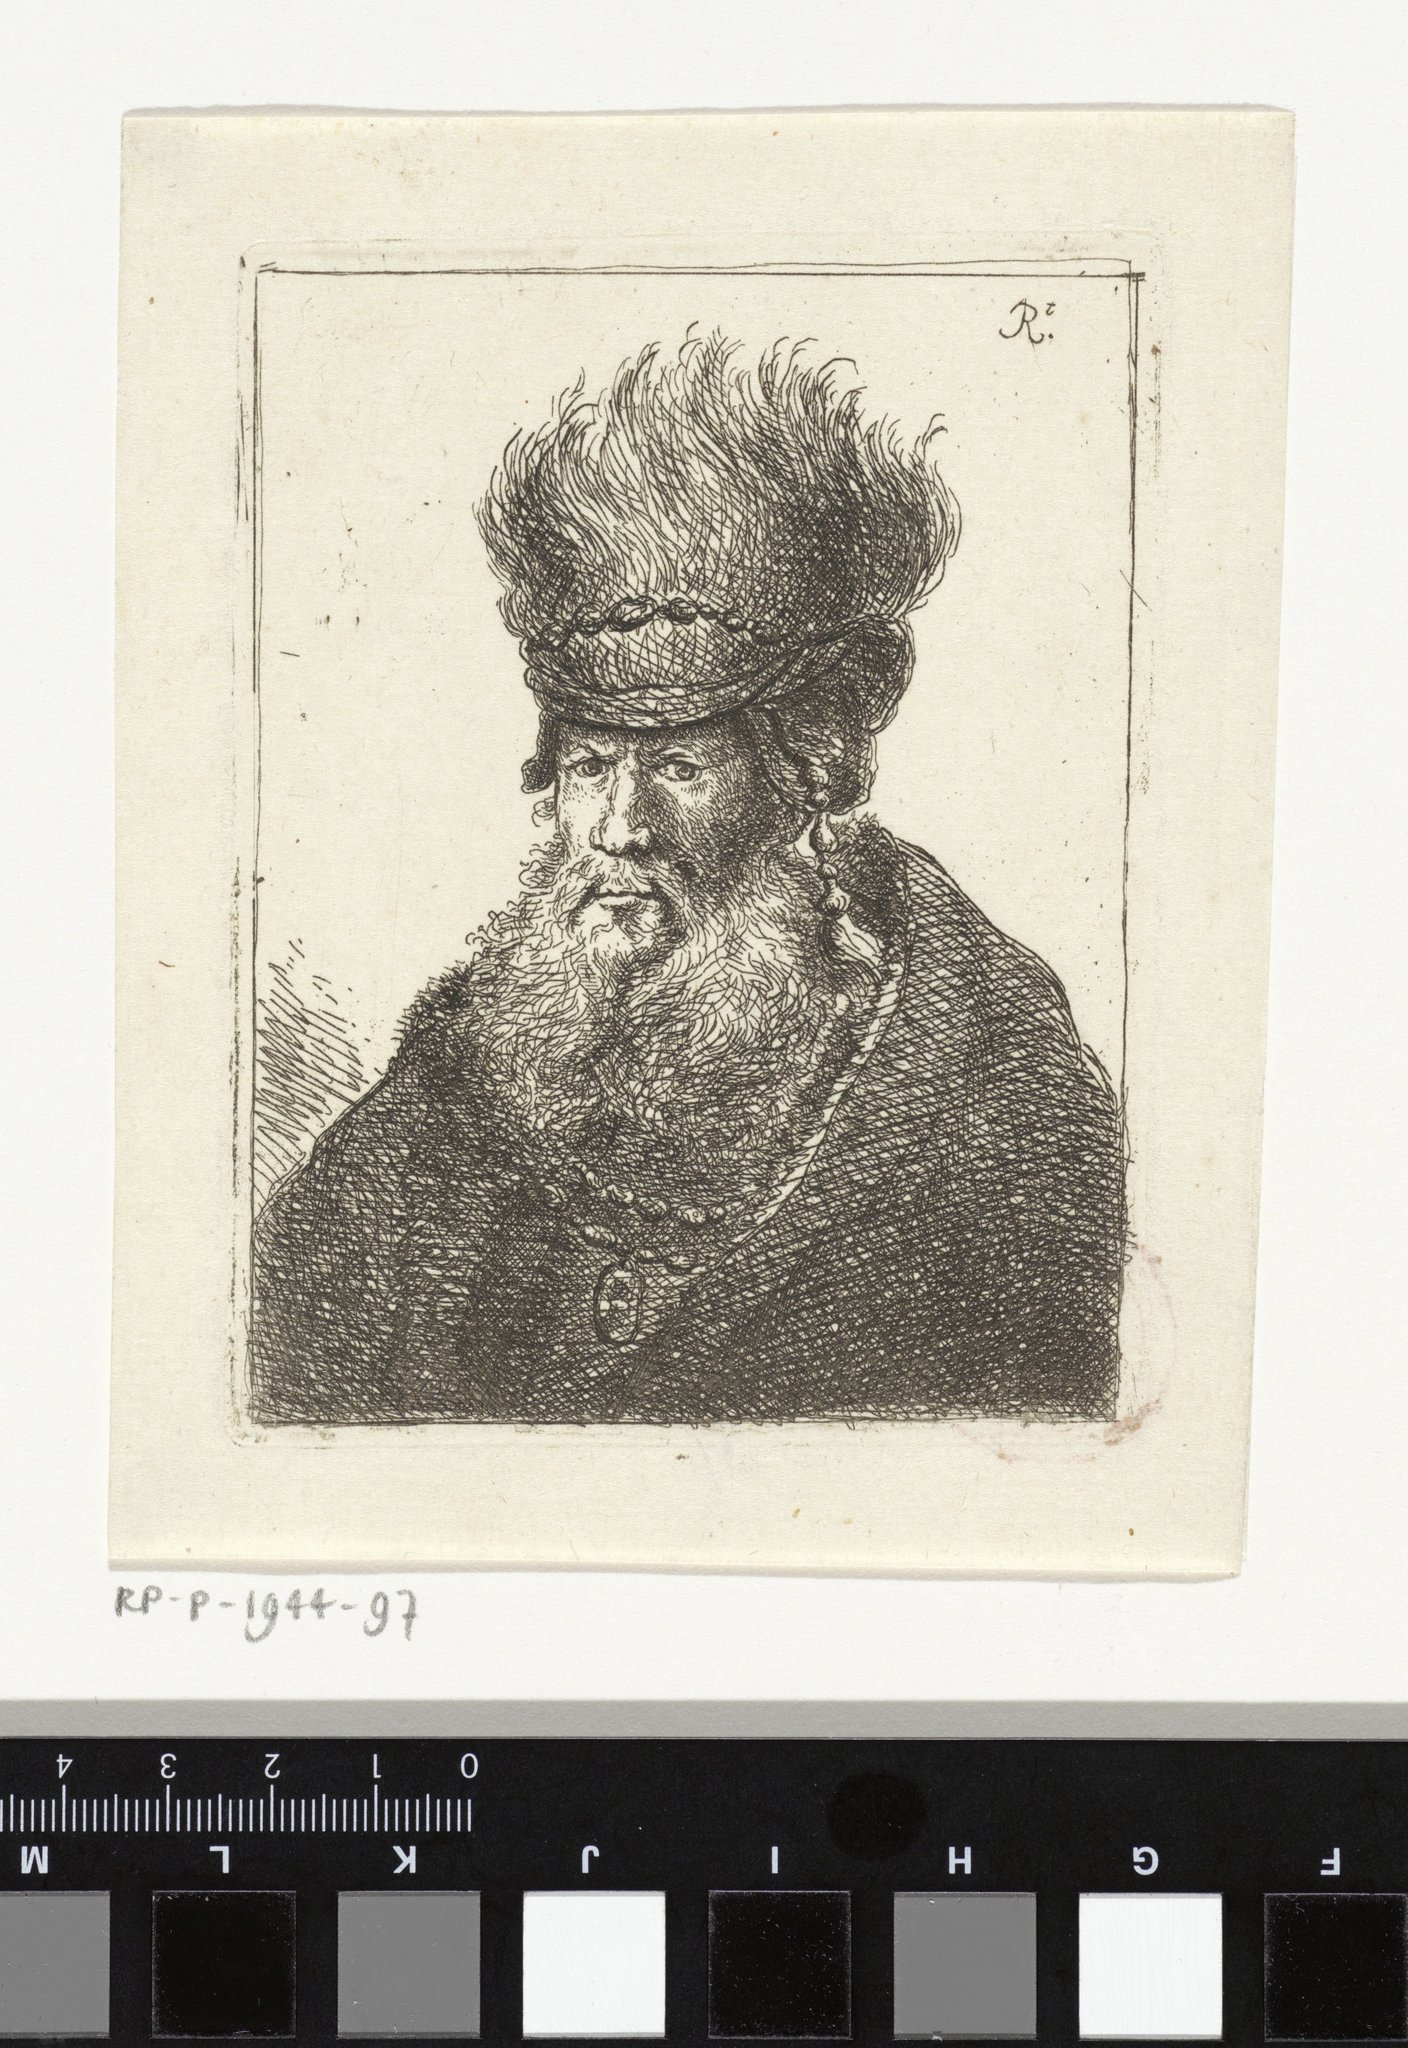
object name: print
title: Portret van een onbekende man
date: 1625-1719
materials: paper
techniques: etching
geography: low countries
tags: anonymous historical person portrayed alone, old man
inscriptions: collector's mark: Lugt 2228, collector's mark: Lugt 240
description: Buste van een onbekende oude man met baard, ketting en muts, driekwart naar links.